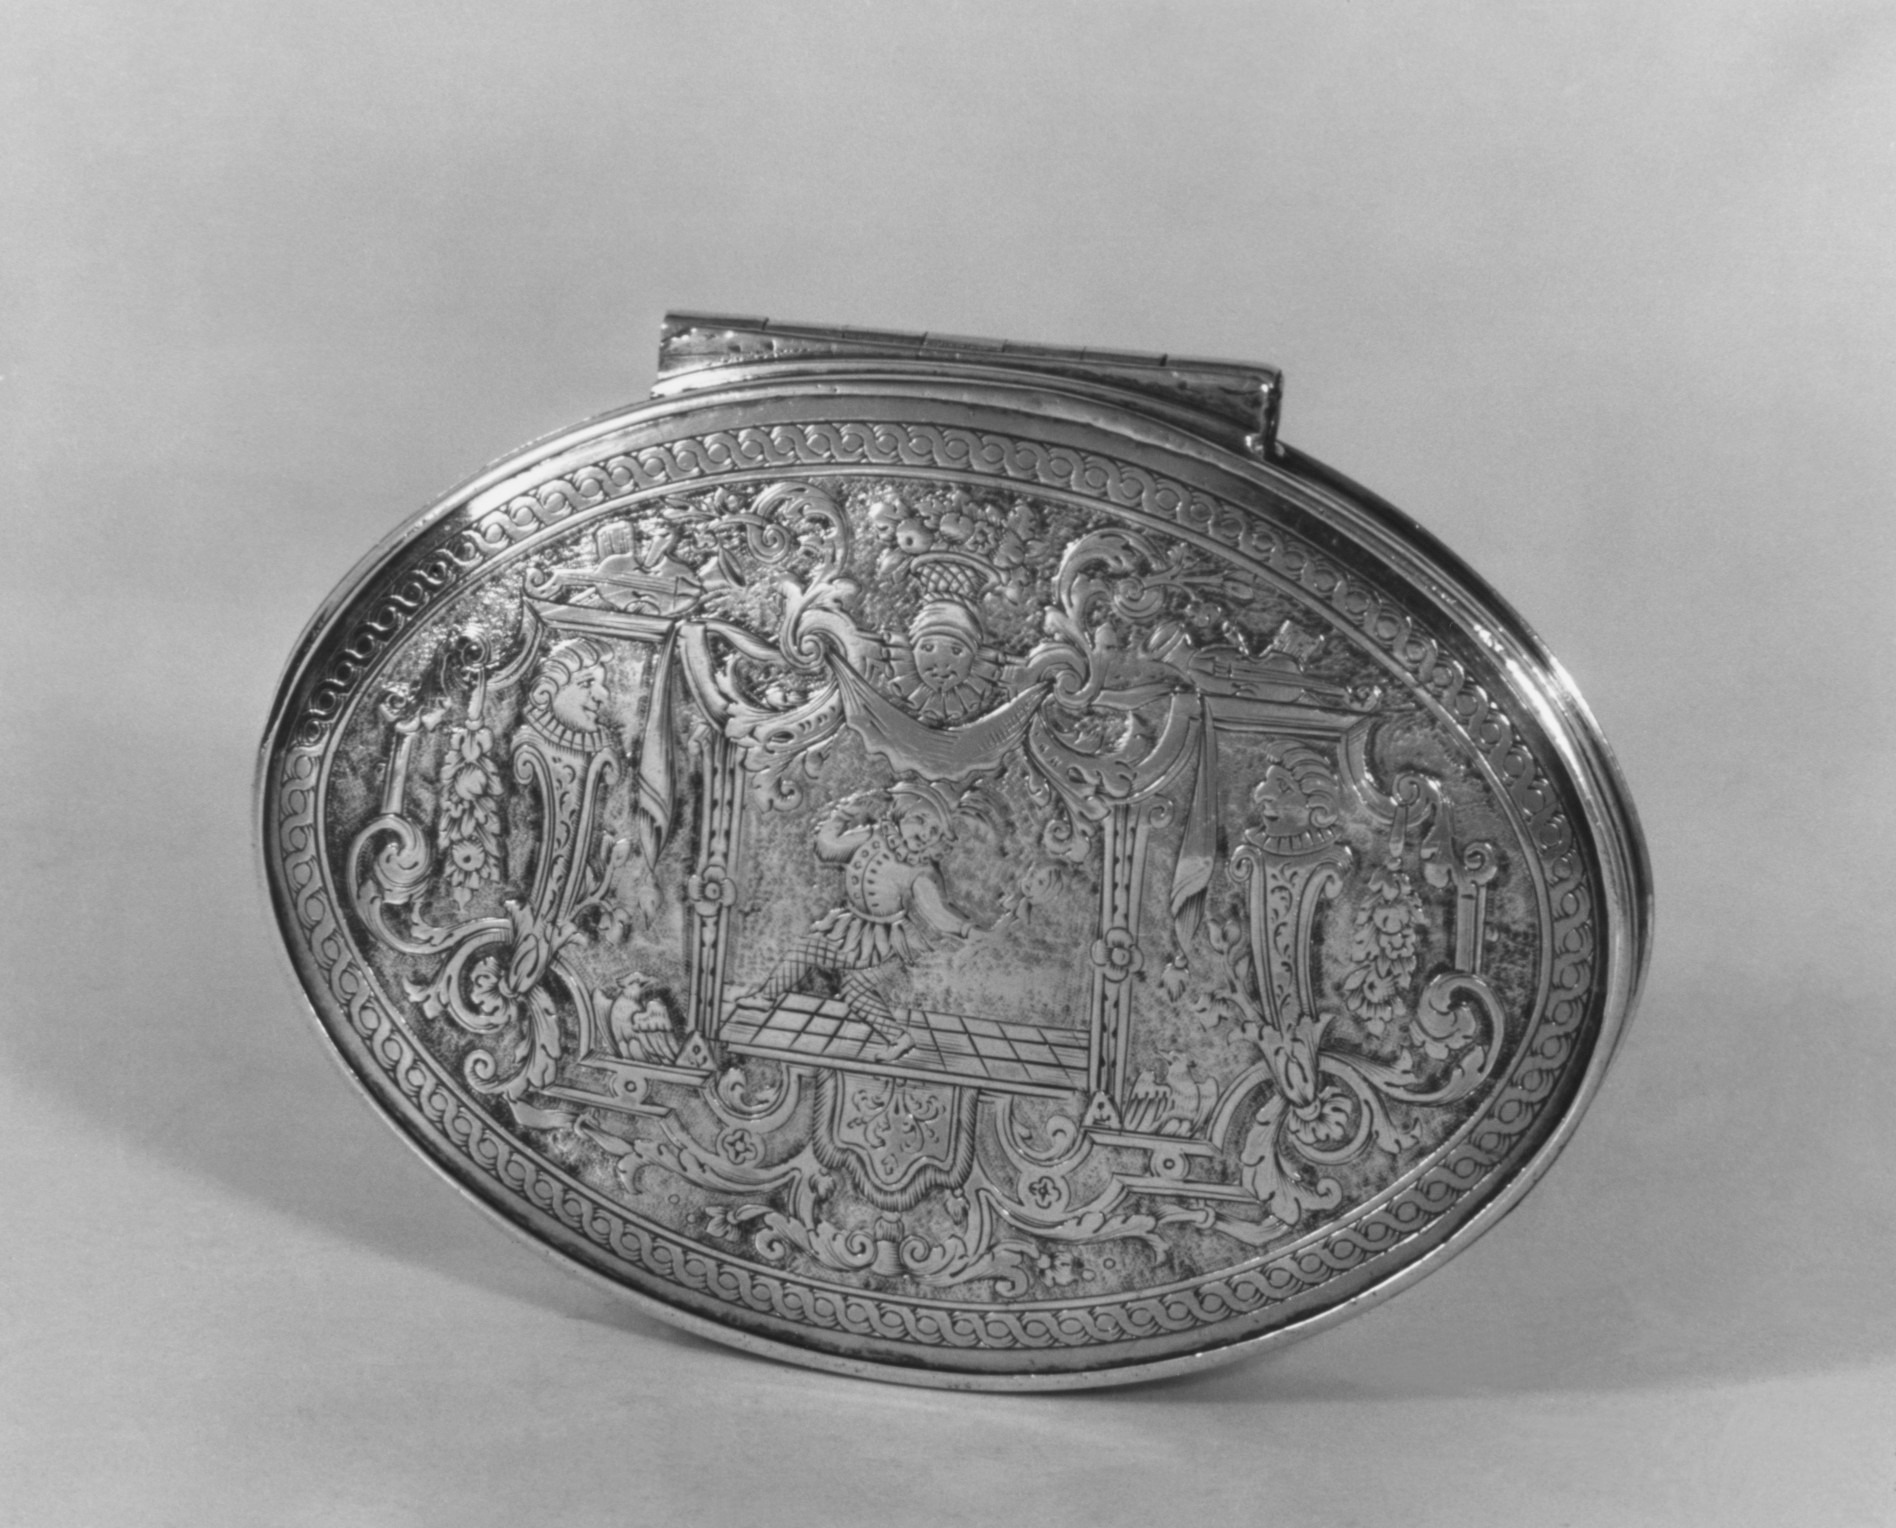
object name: snuffbox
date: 1700-1725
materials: gilt, silver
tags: human figures